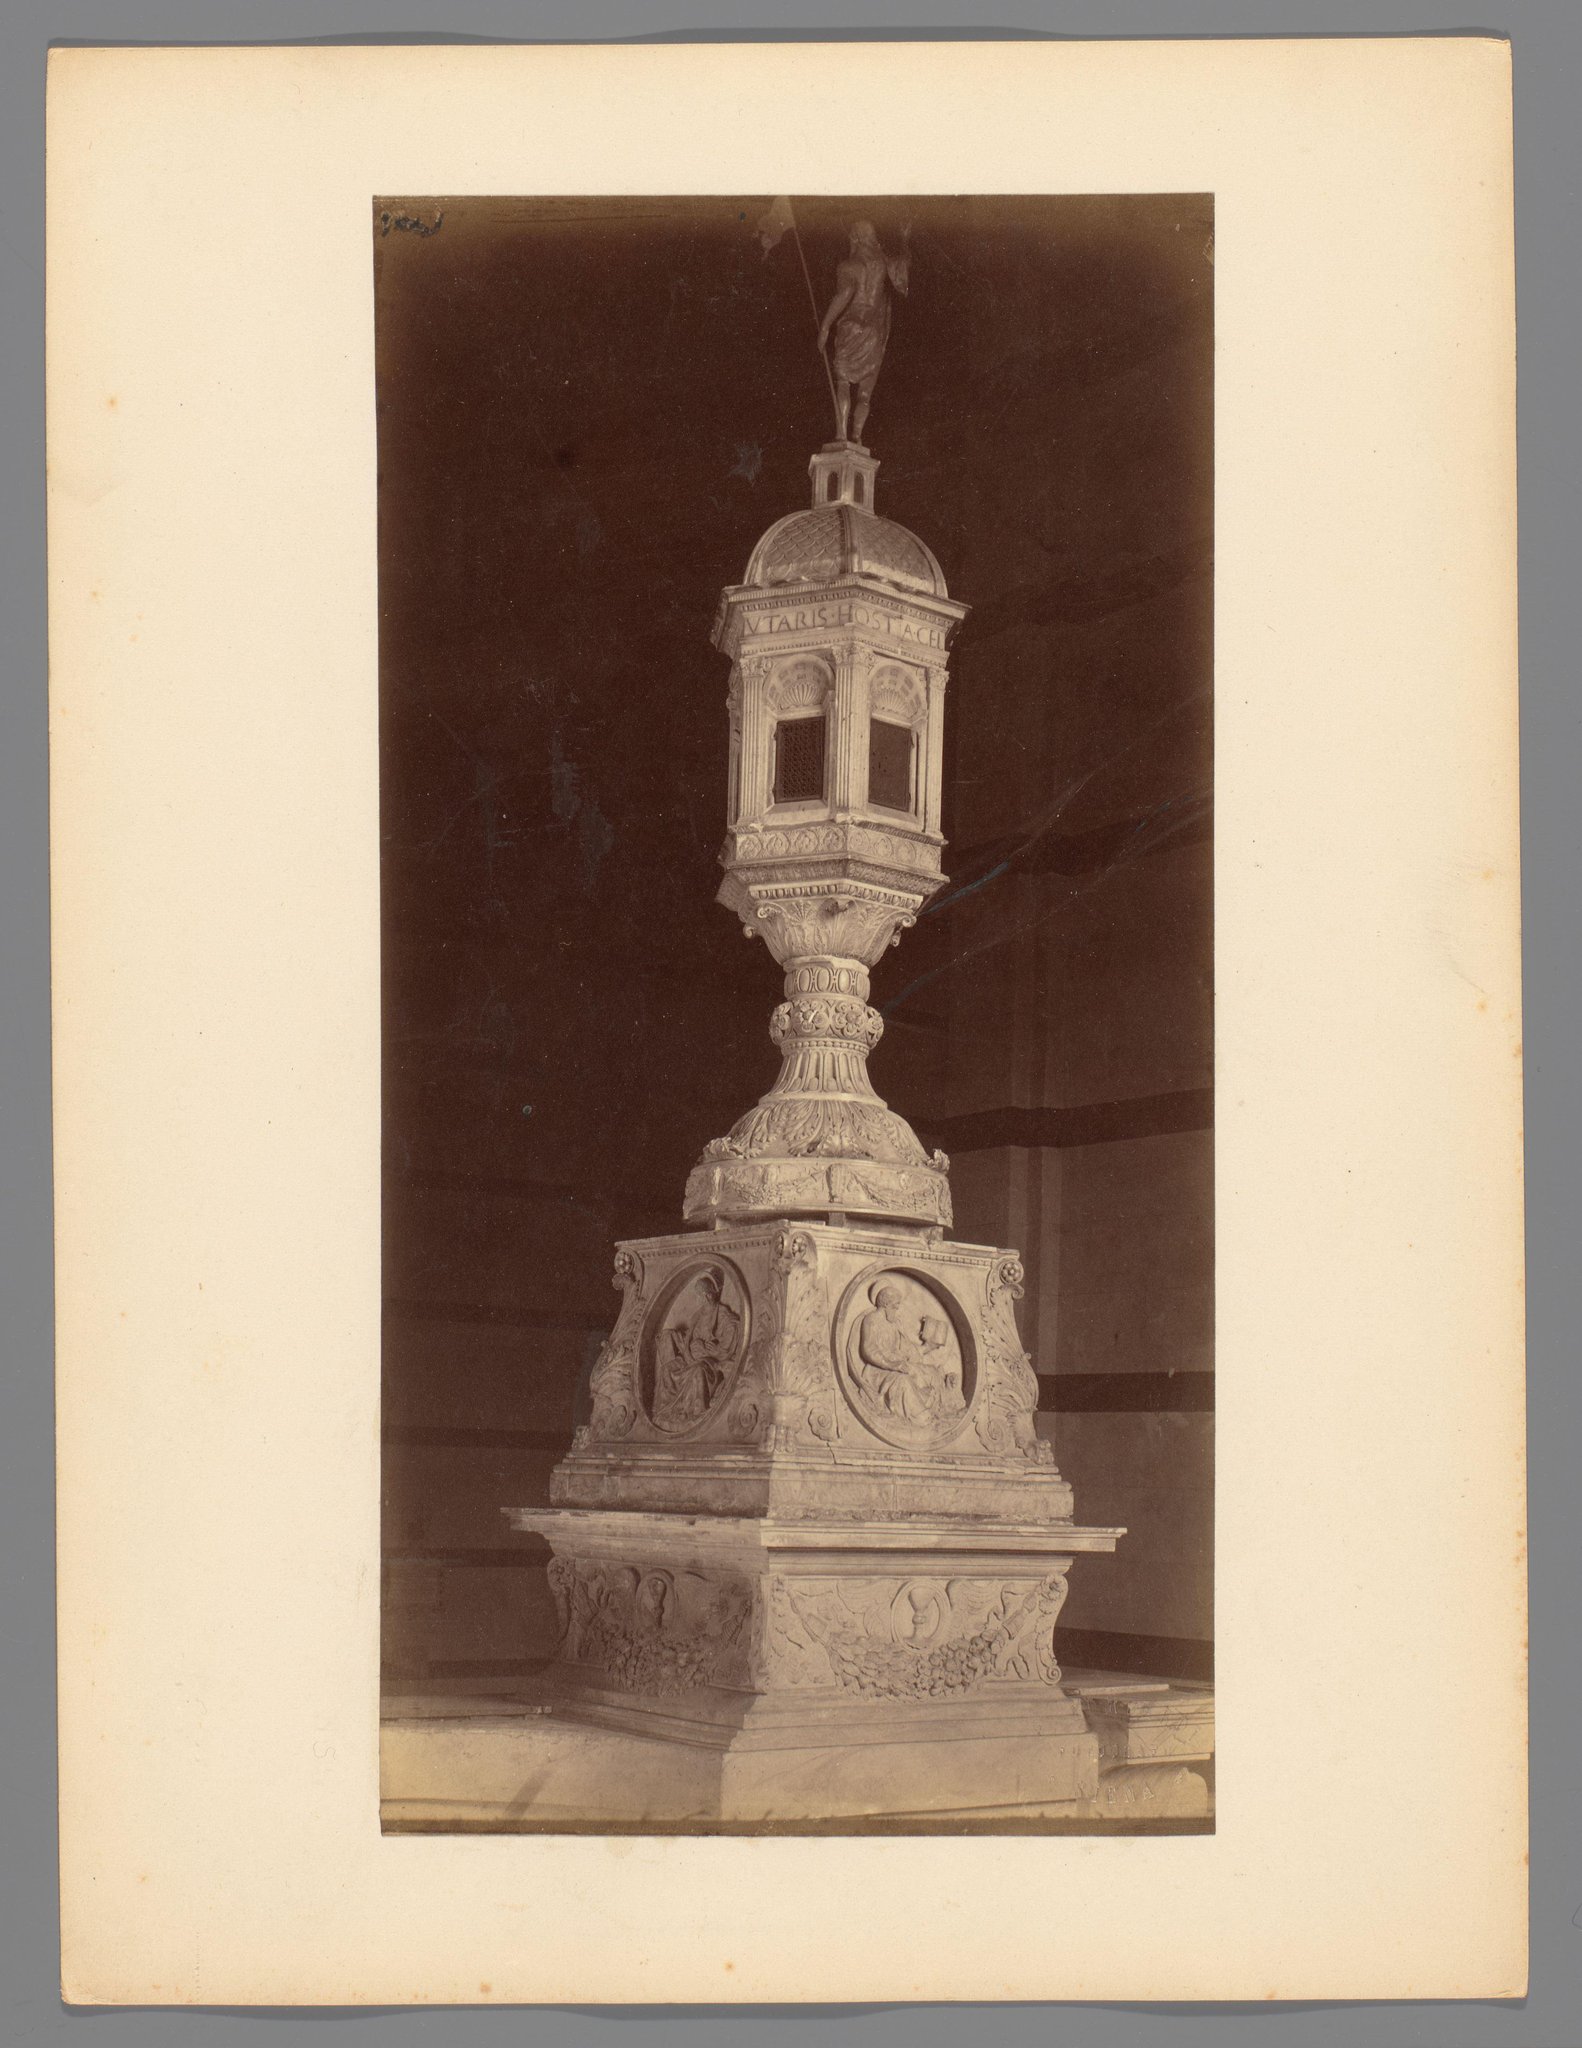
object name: photograph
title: Tabernakel van de Sint-Dominicusbasiliek te Siena met Christus en de vier evangelisten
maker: paolo lombardi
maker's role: fotograaf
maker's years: 1827-1890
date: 1875-1900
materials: cardboard, photographic support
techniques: albumen print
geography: siena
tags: the four evangelists ~ other themes, christ, tabernacle ~ altar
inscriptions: name: ‘P. Lombardi Fotografo Siena’, collector's mark: Lugt 3937